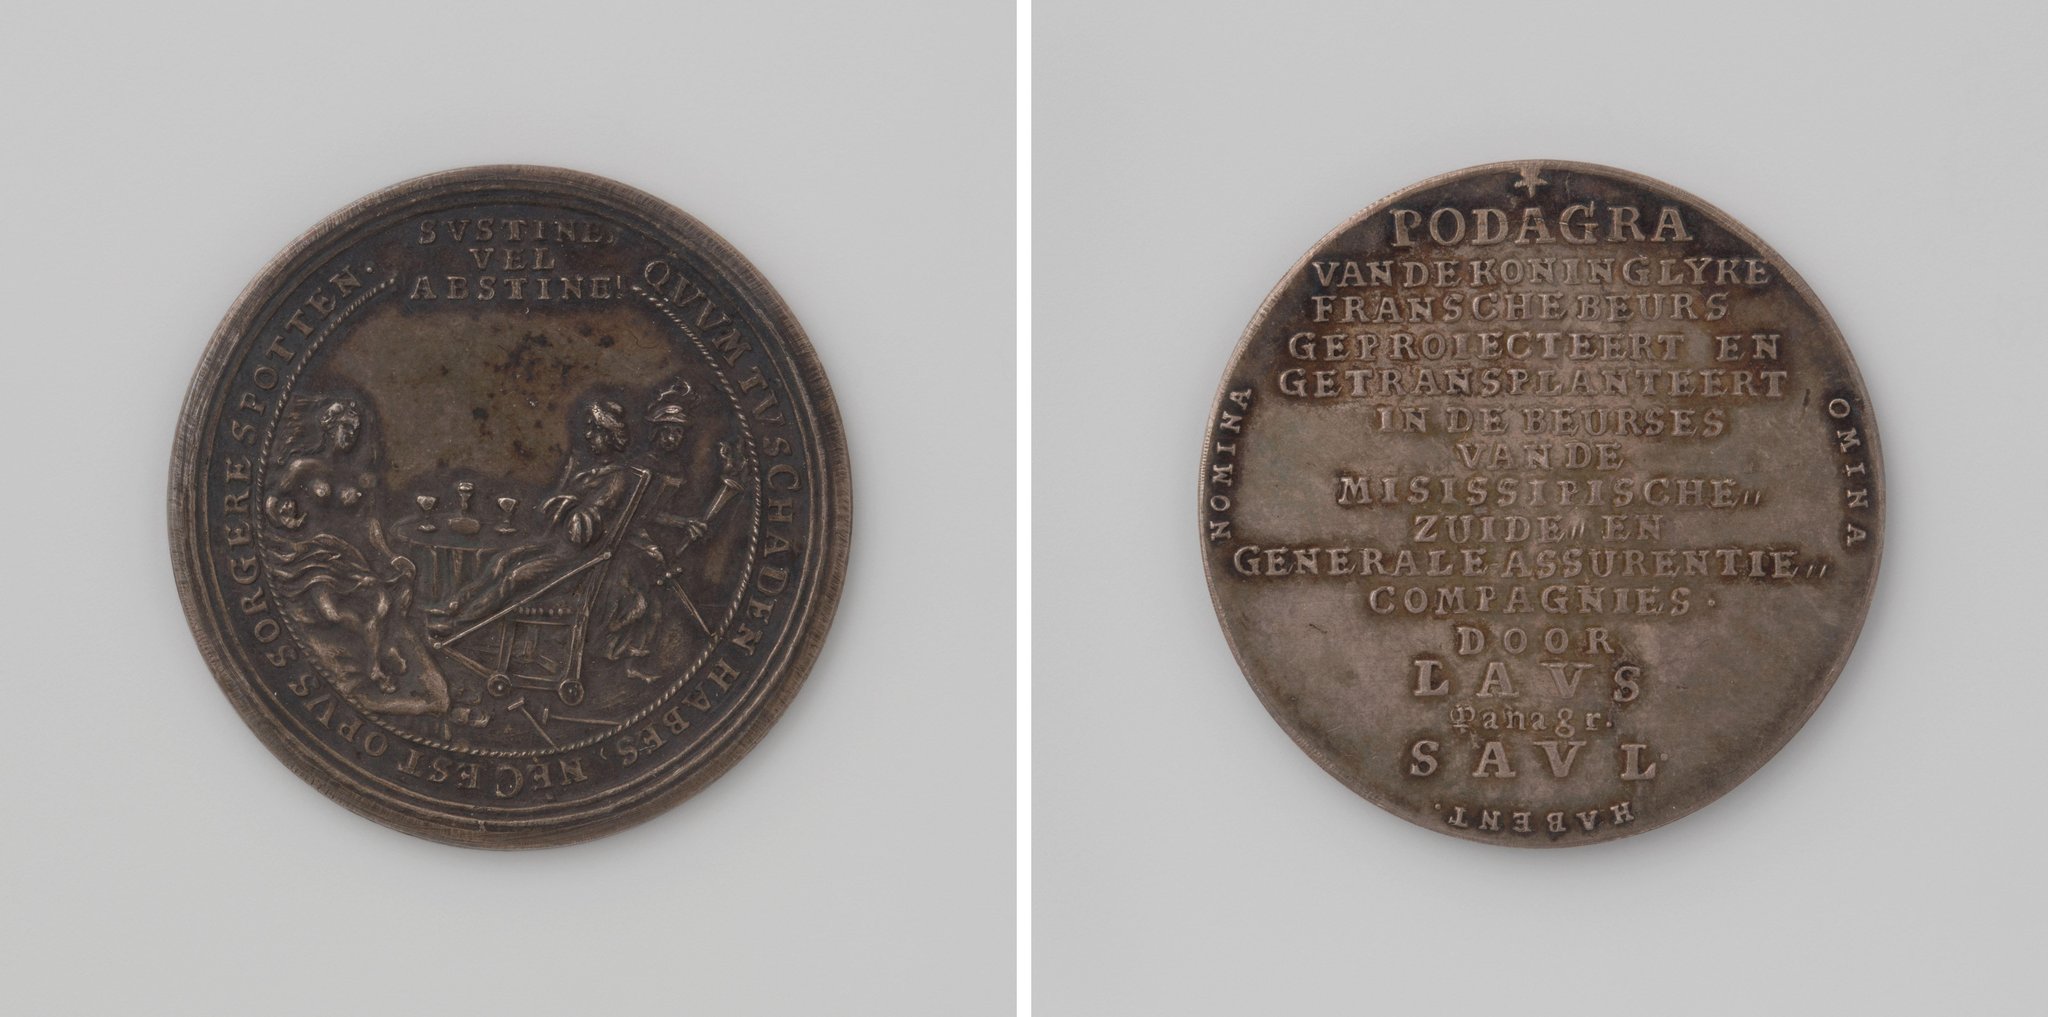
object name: satirical medal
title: Op de actiehandel. De podagra van de Franse beurs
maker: Anonymous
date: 1720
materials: silver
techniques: striking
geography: netherlands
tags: france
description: Zilveren penning. Voorzijde: man zittend aan tafel, waarop bekers staan, in stoel op wielen, achter hem man met fakkel en dolk, naast hem halfnaakte vrouw liggend op bank onder opschrift, binnen omschrift. Keerzijde: opschrift onder ster, binnen omschrift.